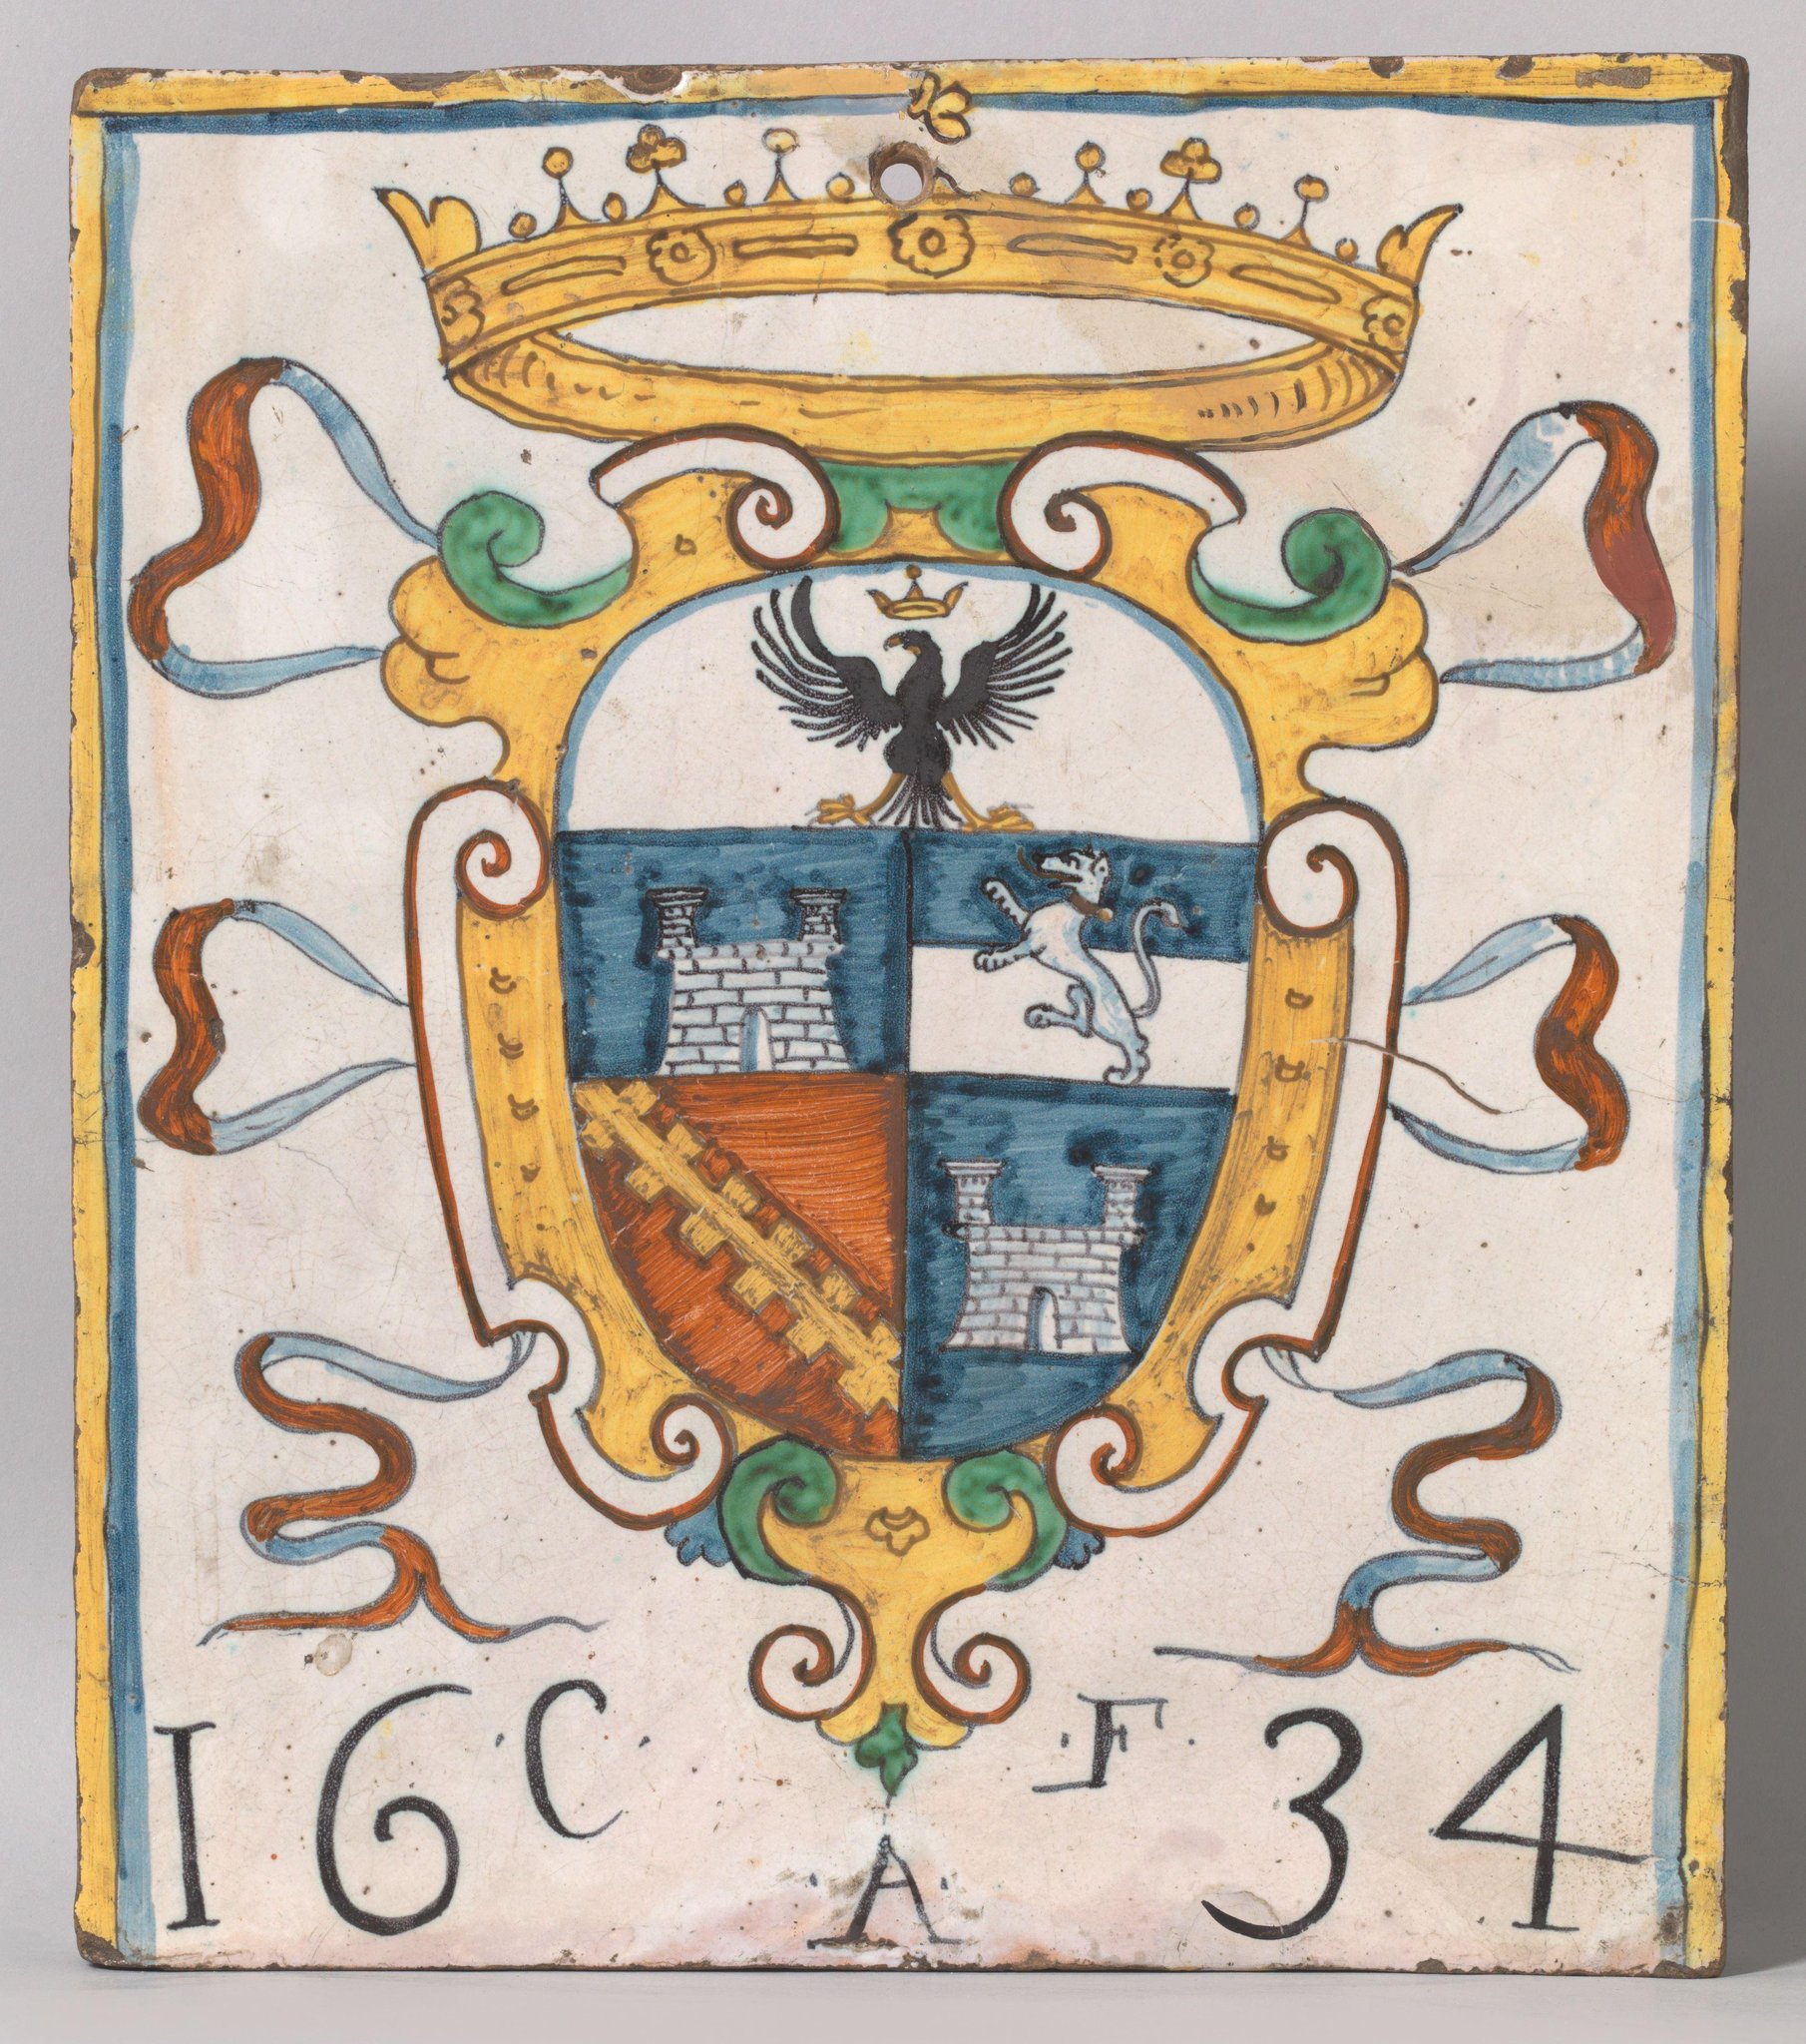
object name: tile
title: Tegel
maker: Anonymous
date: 1634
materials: earthenware, glaze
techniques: maiolica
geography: italy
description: Tegel met een veelkleurig (blauw, geel, groen en bruin) gekroond wapen met onderaan het jaartal: 1634 en de letters: C A F.